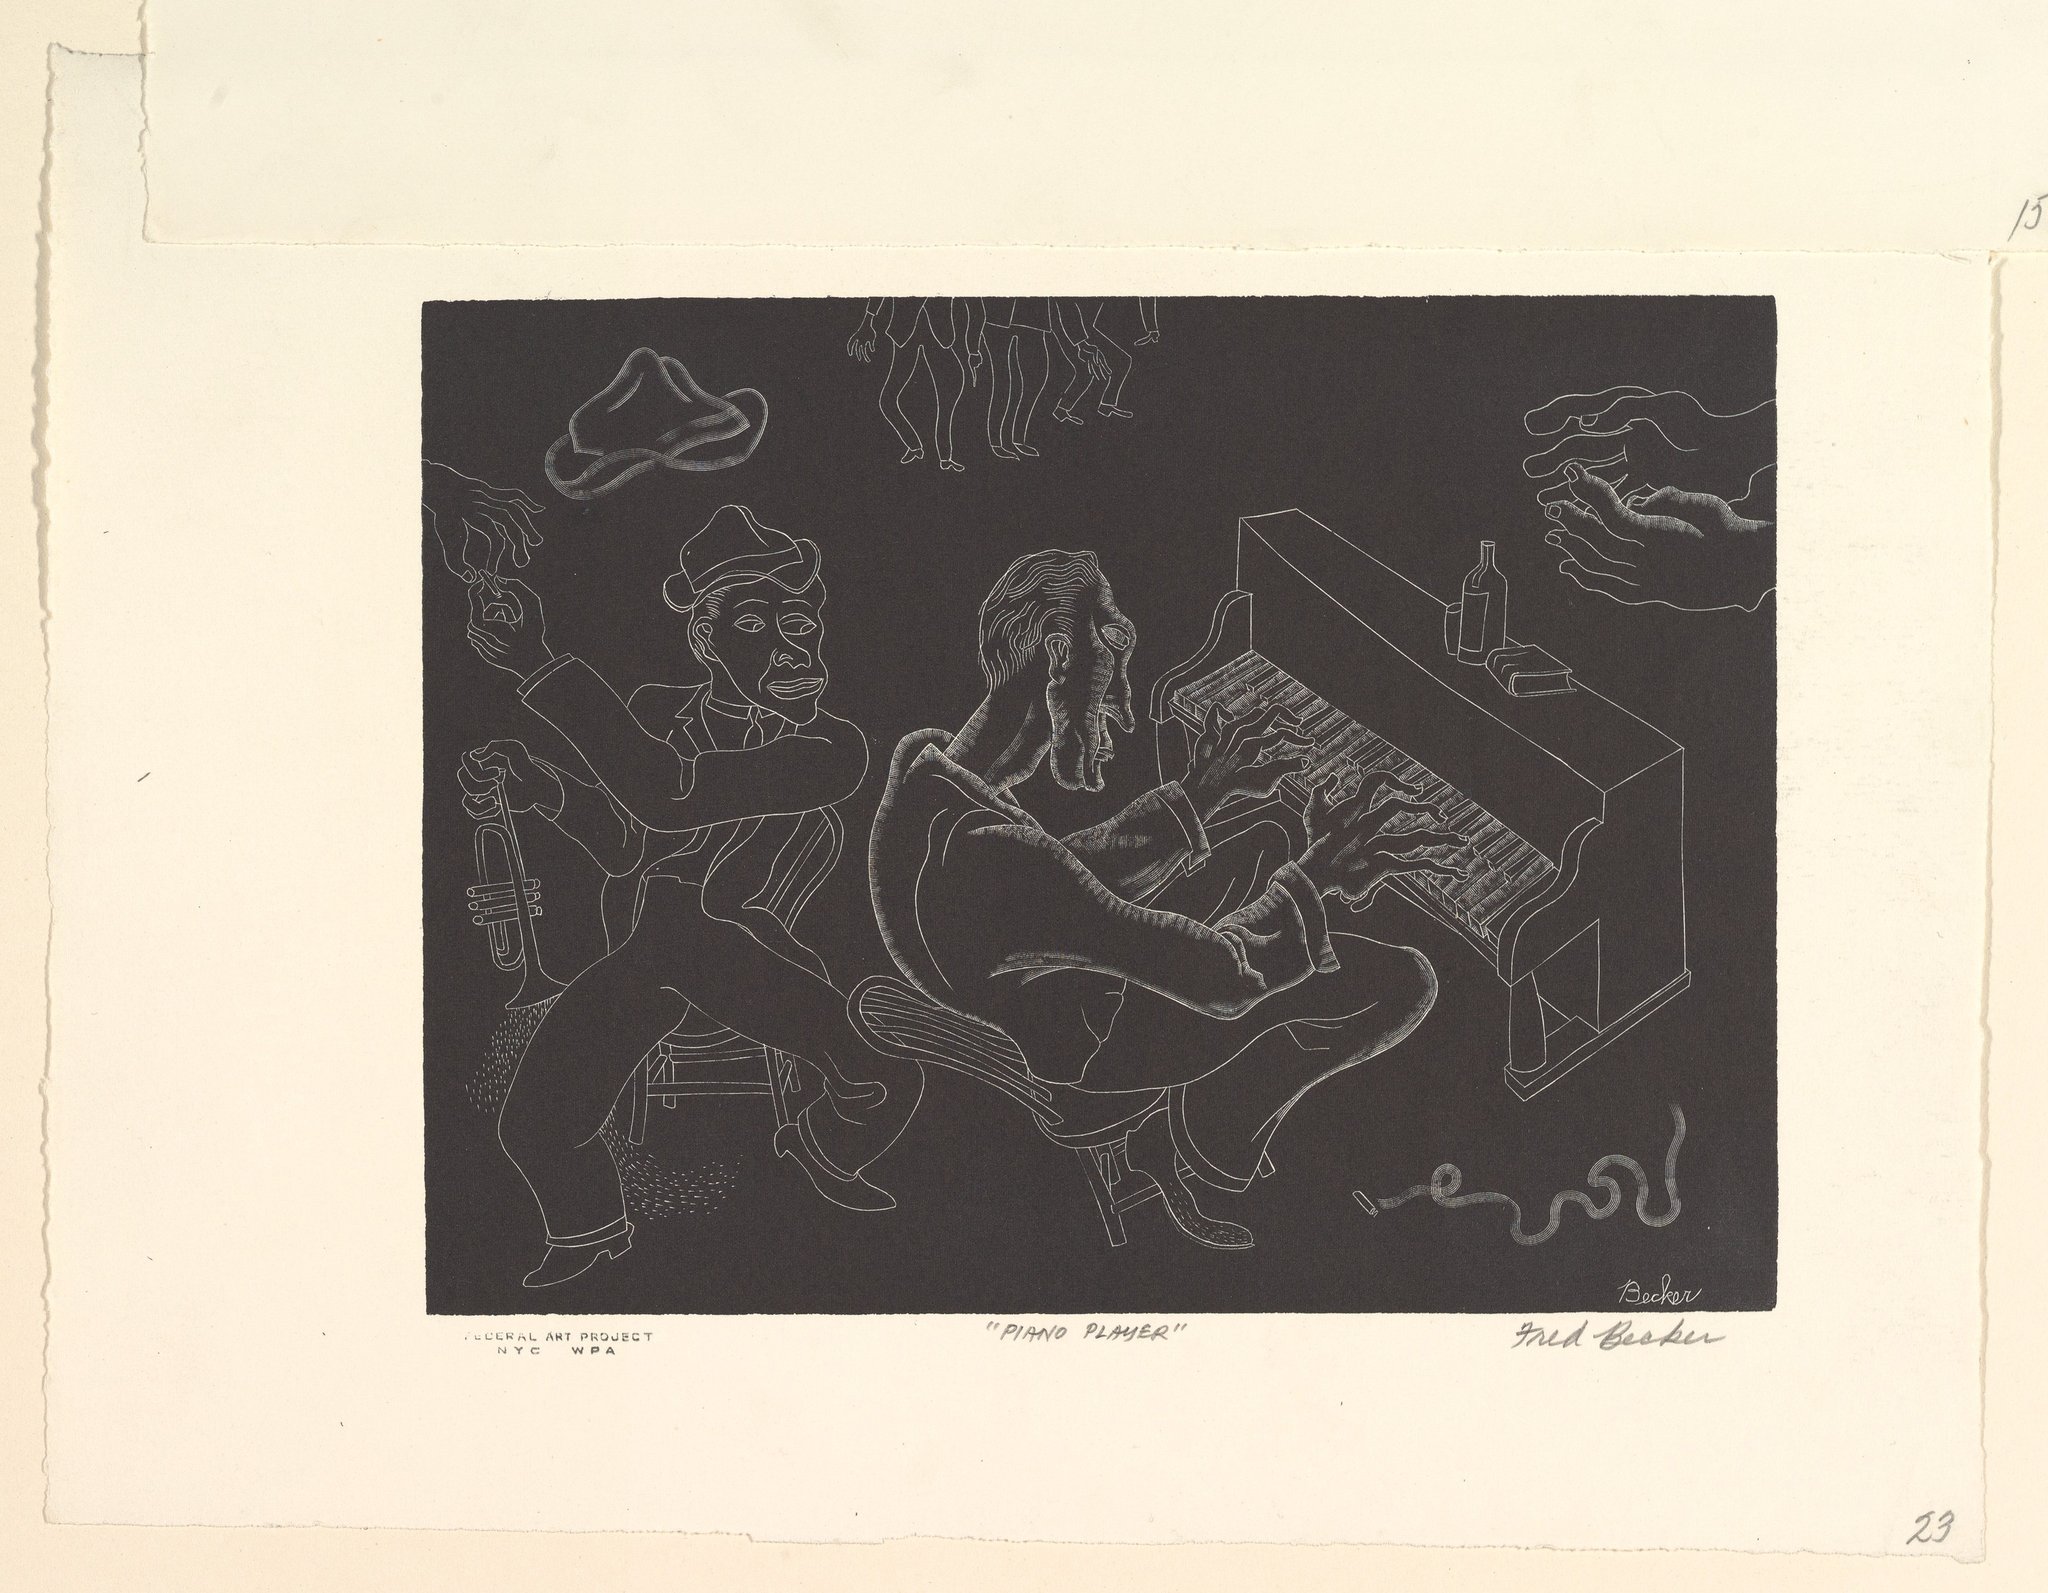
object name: print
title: Piano Player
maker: fred becker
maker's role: artist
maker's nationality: american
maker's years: 1913-2004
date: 1935-1940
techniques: engraving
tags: men,pianos,trumpets,musicians